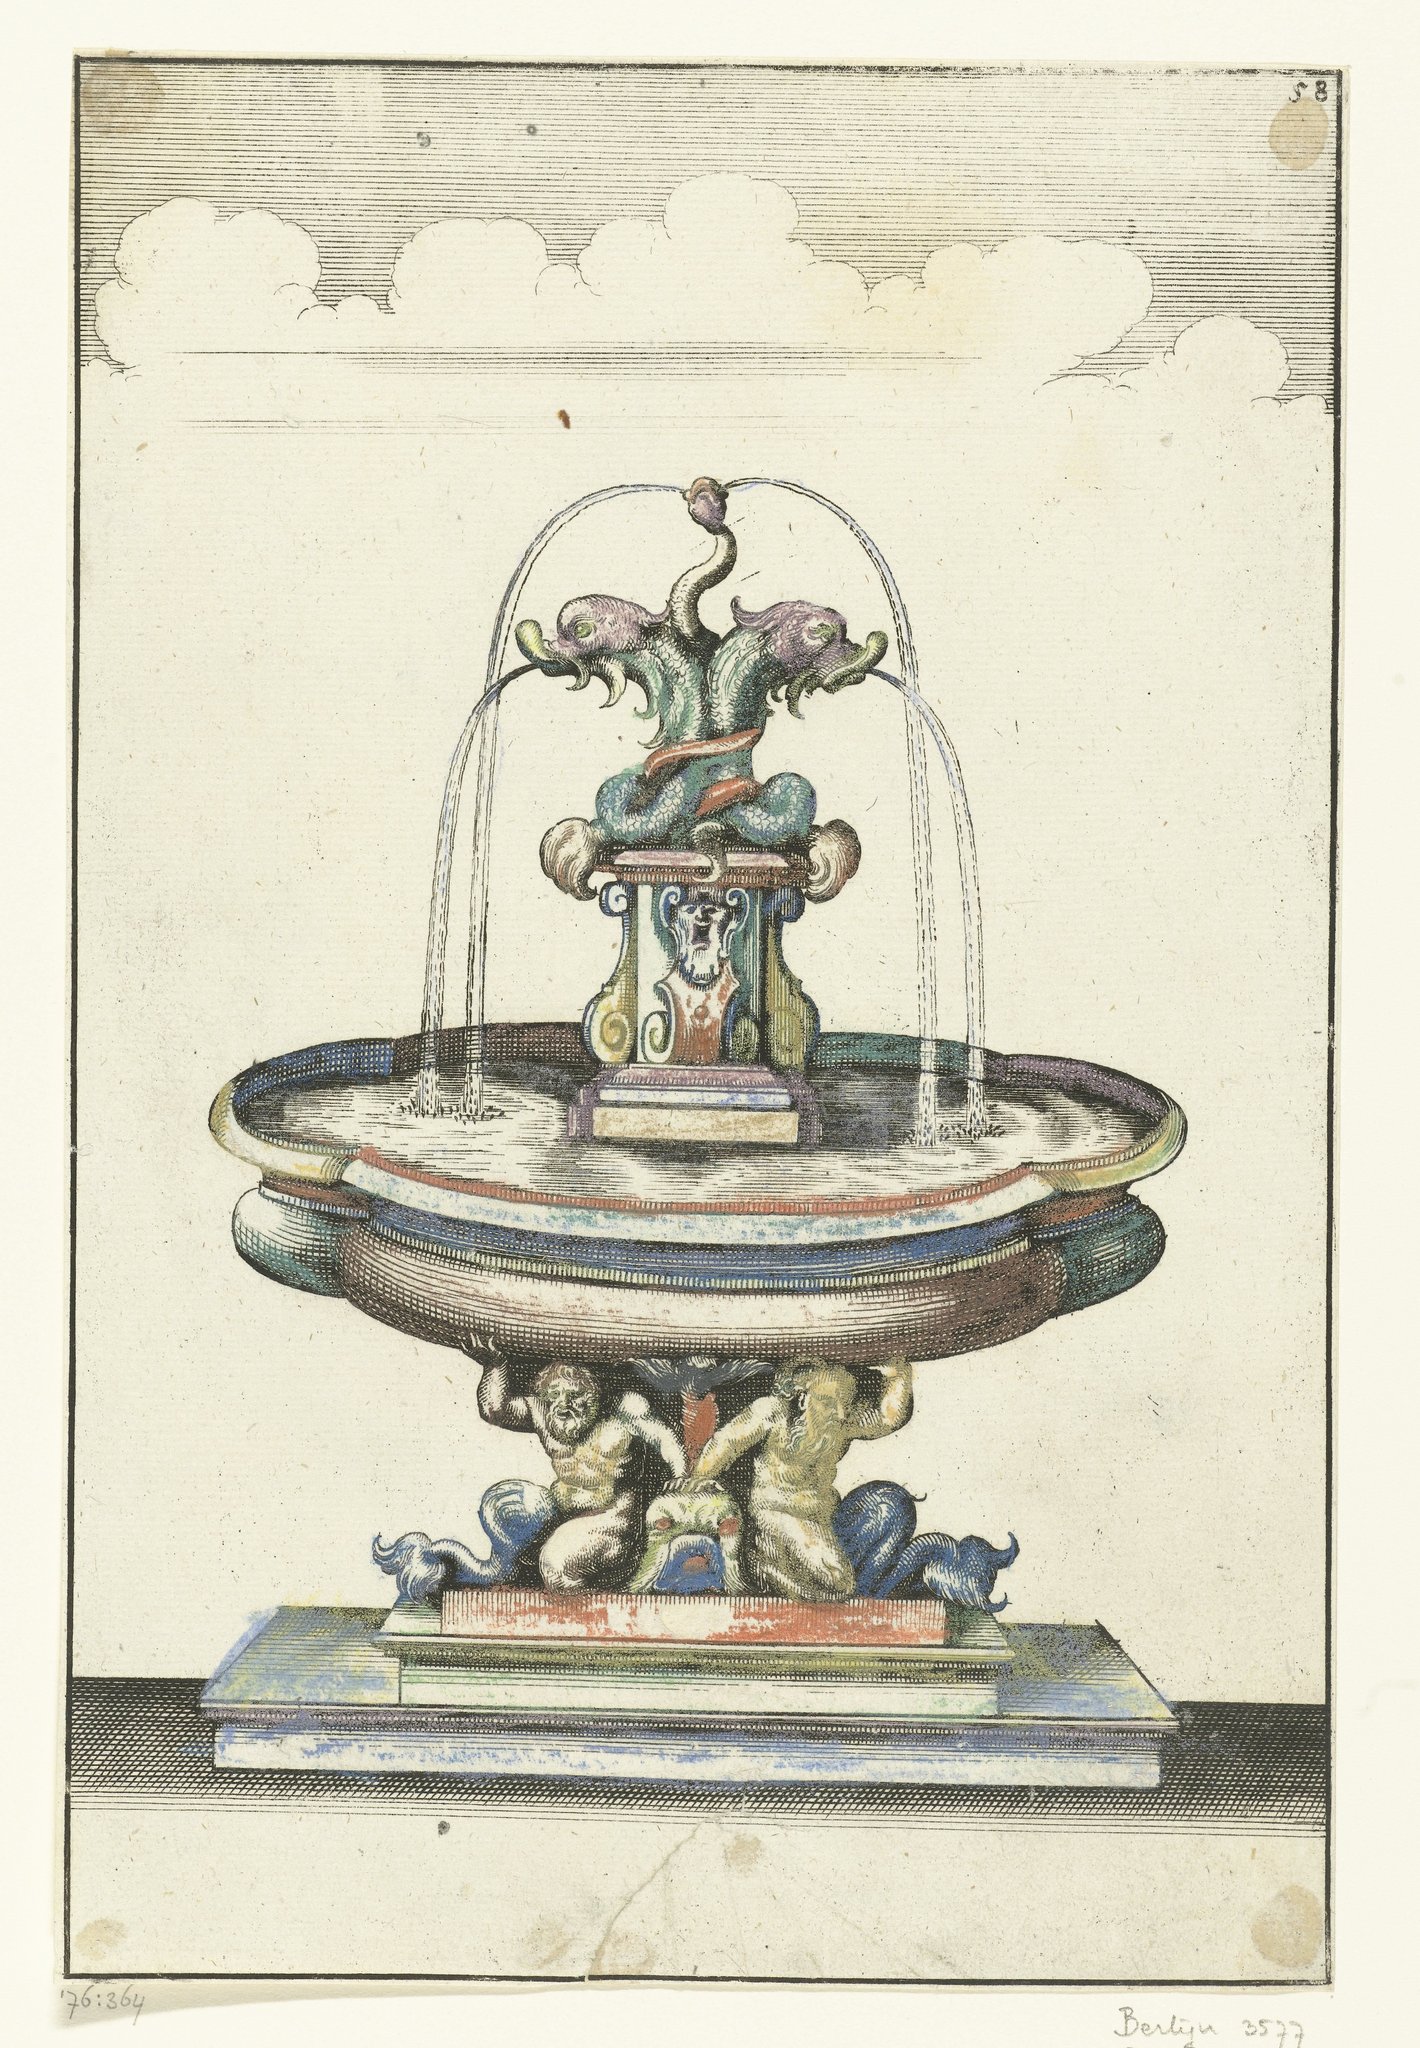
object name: ornament print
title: Architectura Curiosa Nova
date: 1664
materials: paper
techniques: etching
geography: germany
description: Het bassin staat op een voetstuk bestaande uit zeemeermannen en dolfijnen. In het bassin staat een tweede voetstuk gedecoreerd met consoles en maskers, waarop twee waterspuitende dolfijnen en een slang staan. Blad 58 uit deel III van een serie bestaande uit 226 bladen, verdeeld over vier boeken, elk met een eigen titelblad.